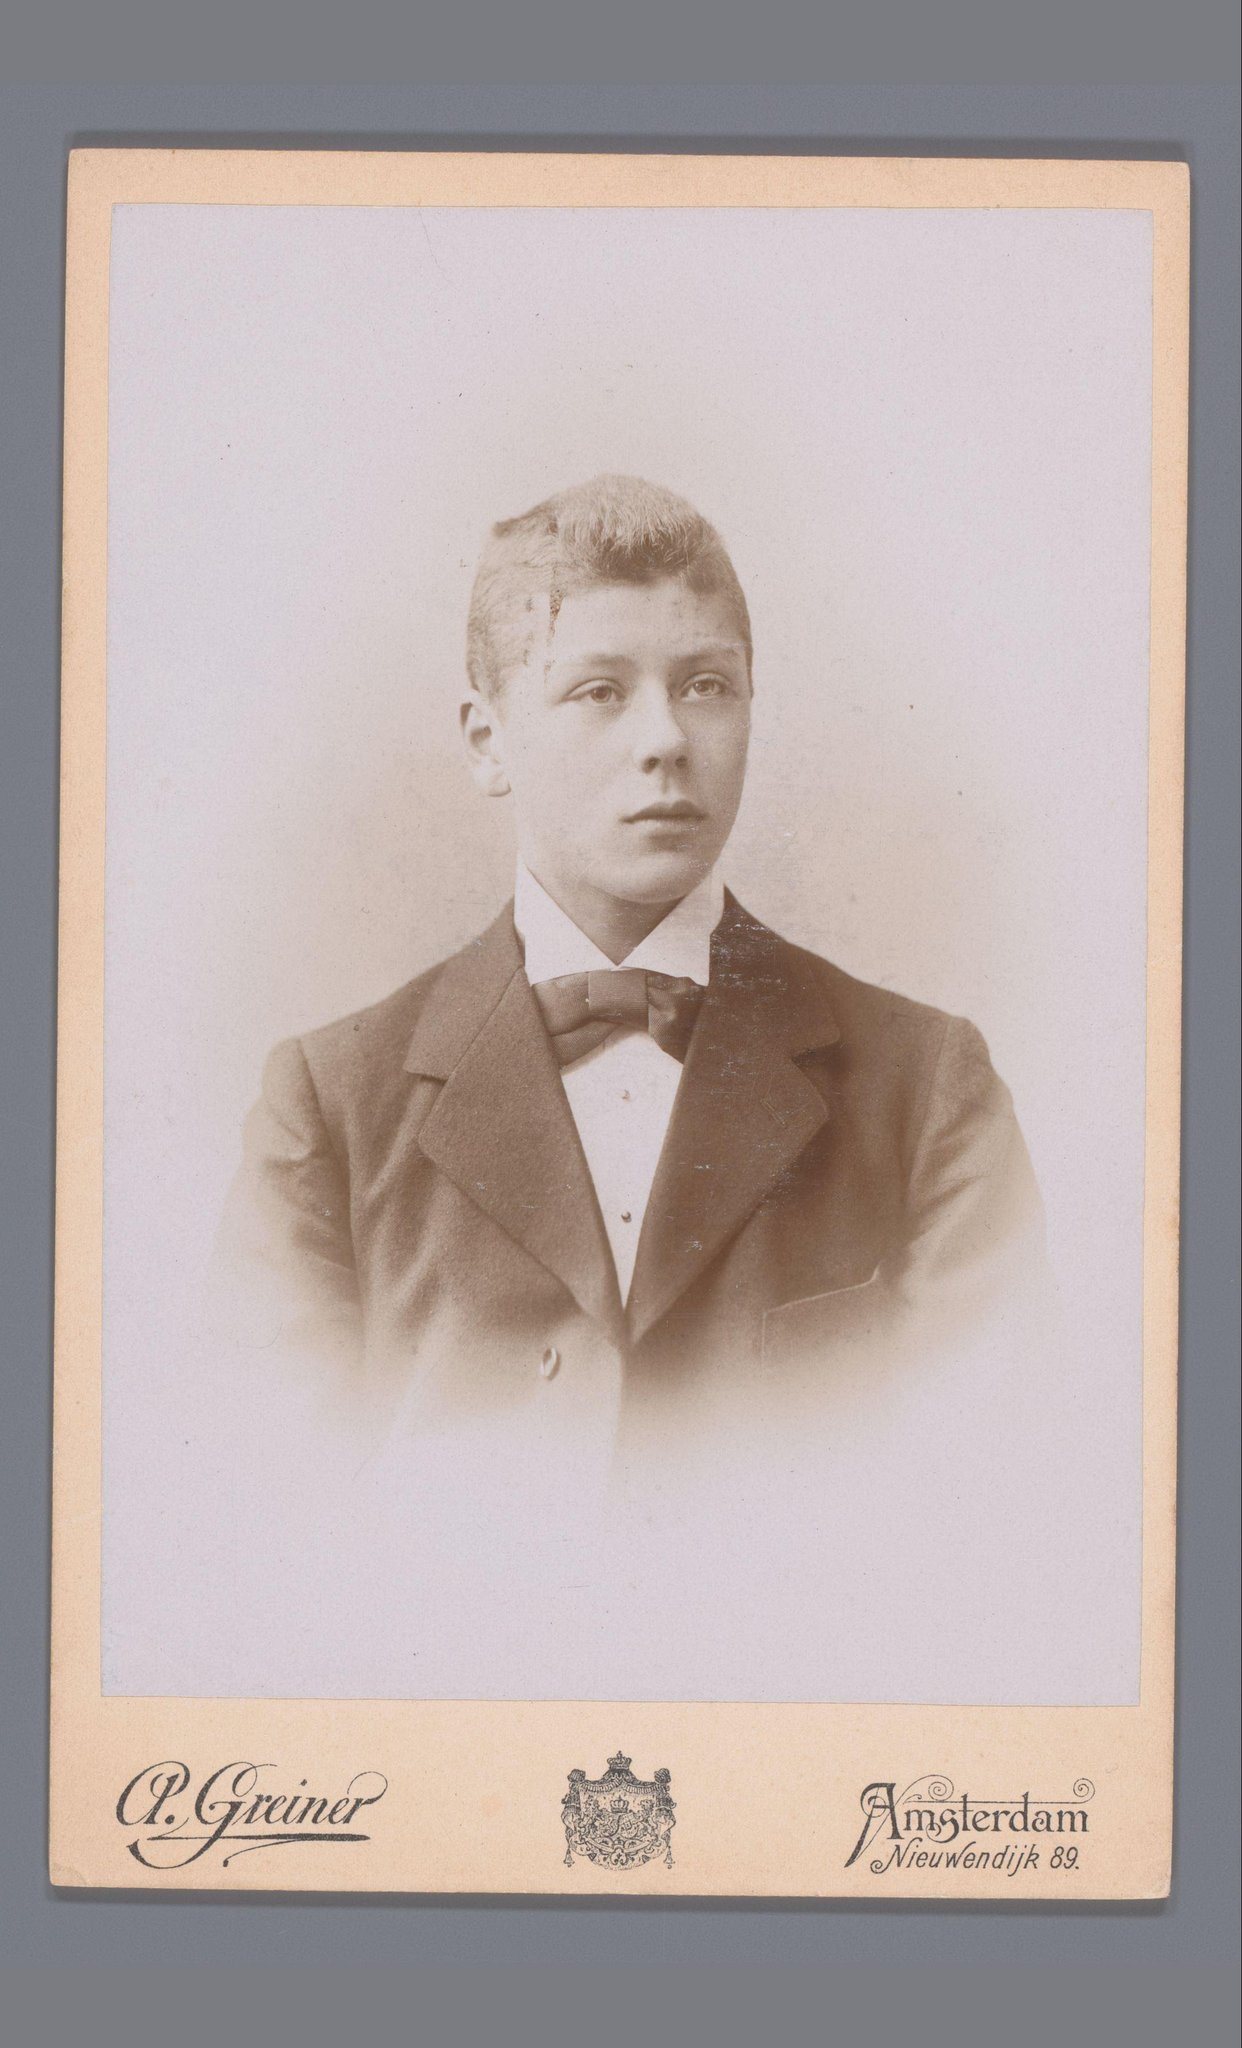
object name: photograph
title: Portret van G.J. Langhout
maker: albert greiner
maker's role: fotograaf, fotostudio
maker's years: 1833-1890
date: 1896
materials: cardboard, photographic support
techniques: collodion silver print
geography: amsterdam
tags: historical persons, amsterdam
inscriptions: annotation: ‘G.J. Langhout ±1896’